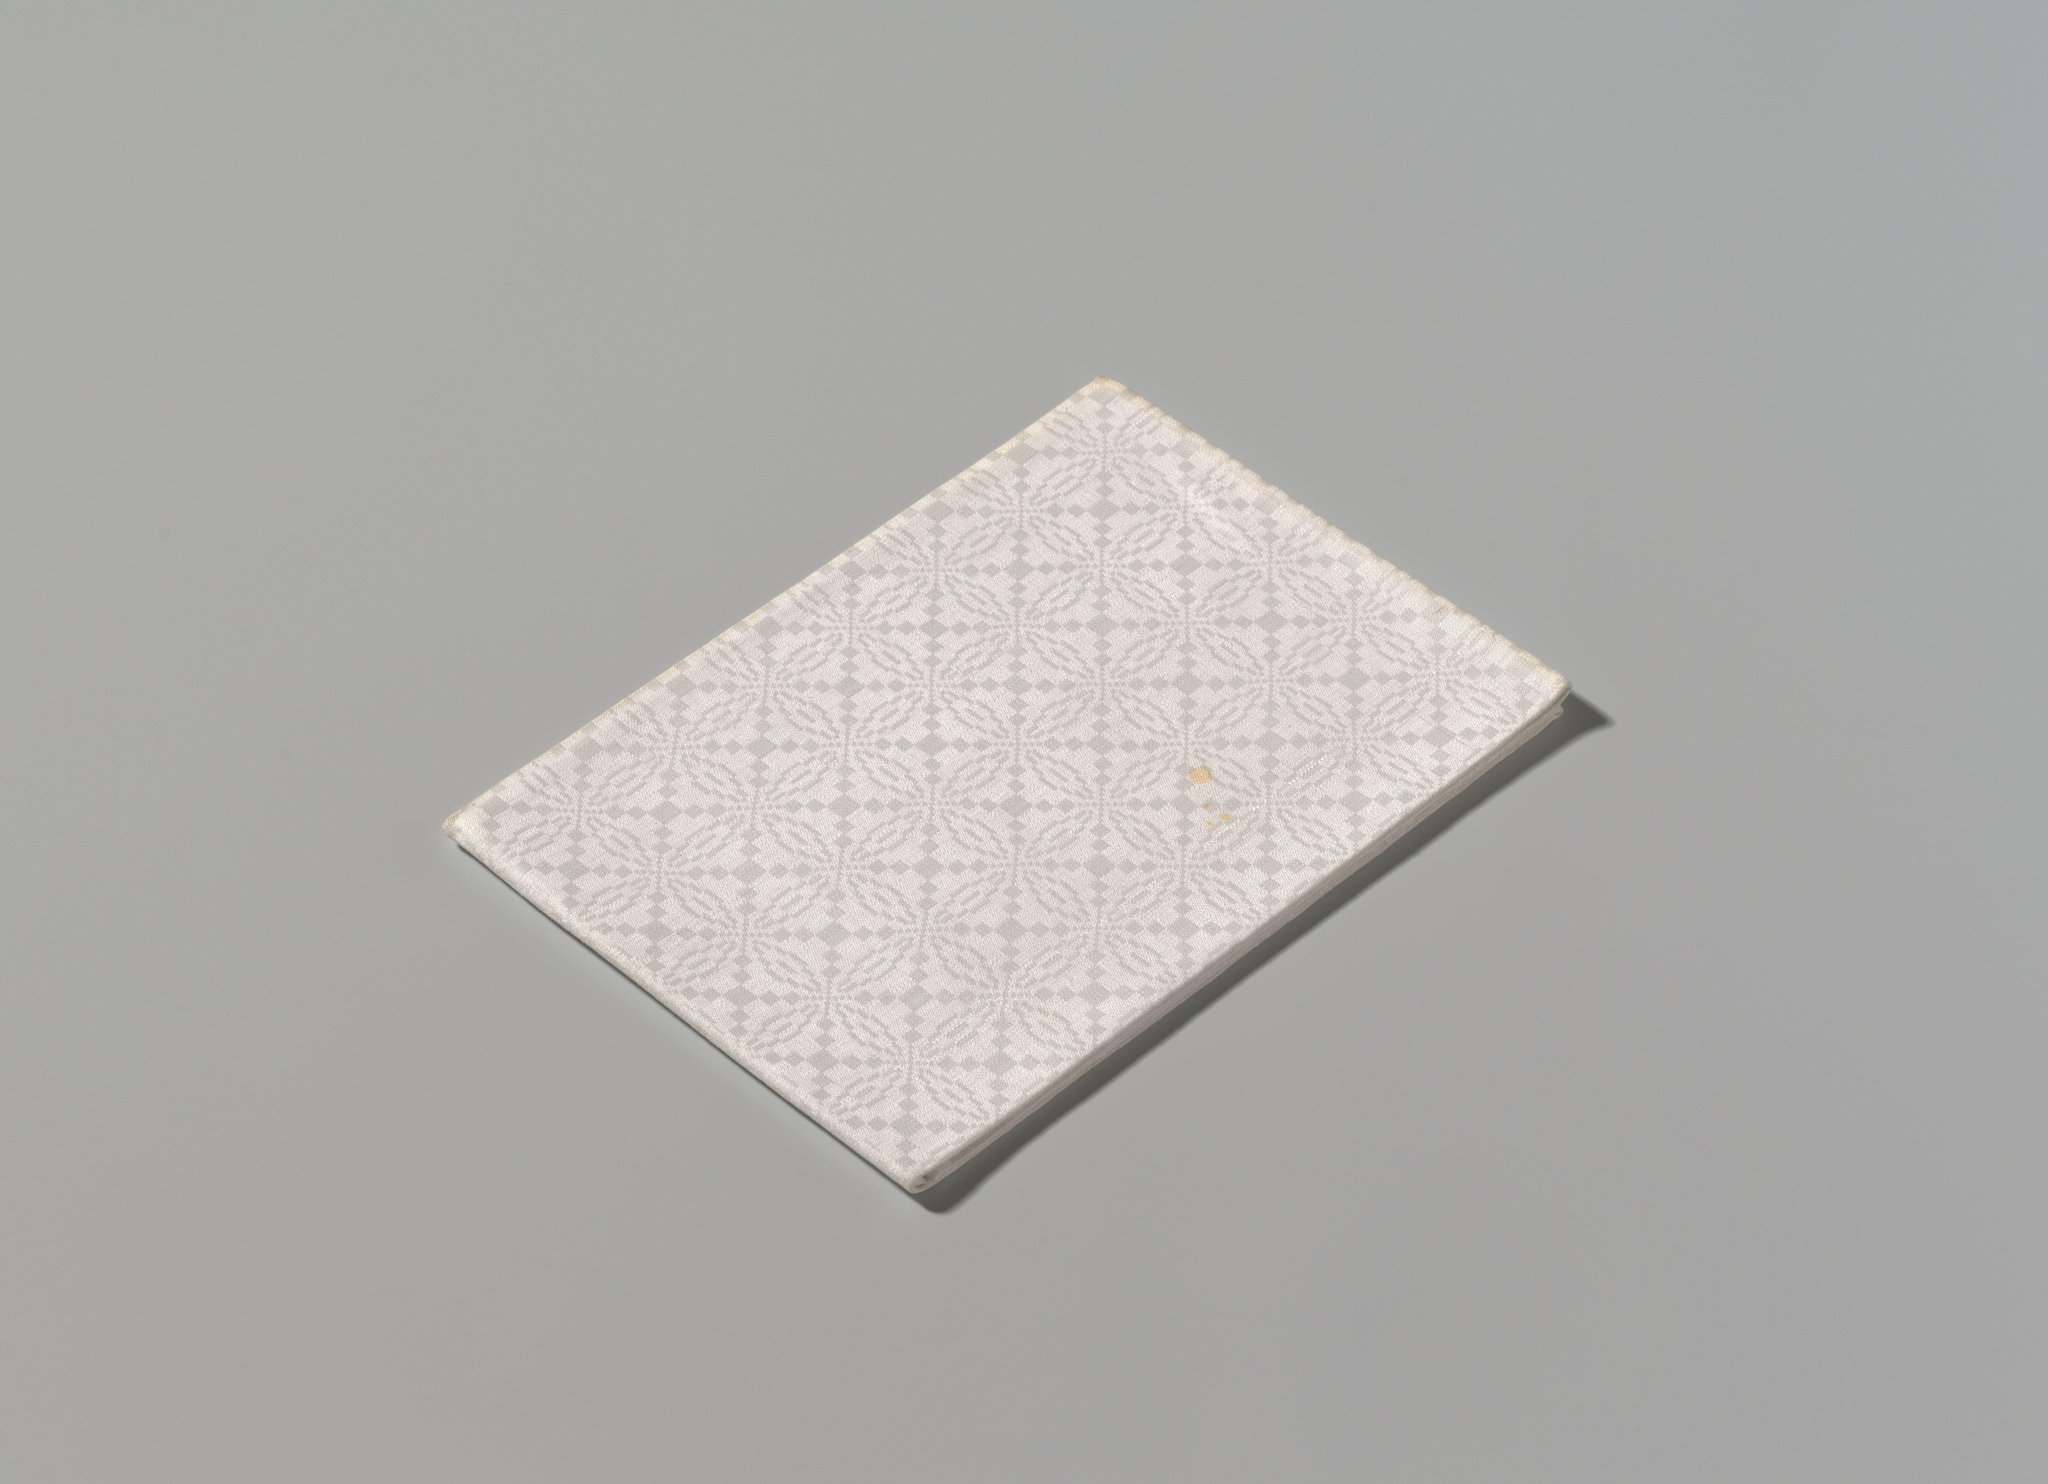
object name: napkin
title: Servet van linnen met pellenpatroon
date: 1620-1660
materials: linen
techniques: peeled fabric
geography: northern netherlands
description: Wit linnen servet met een pellen patroon. Merk AVR HB.